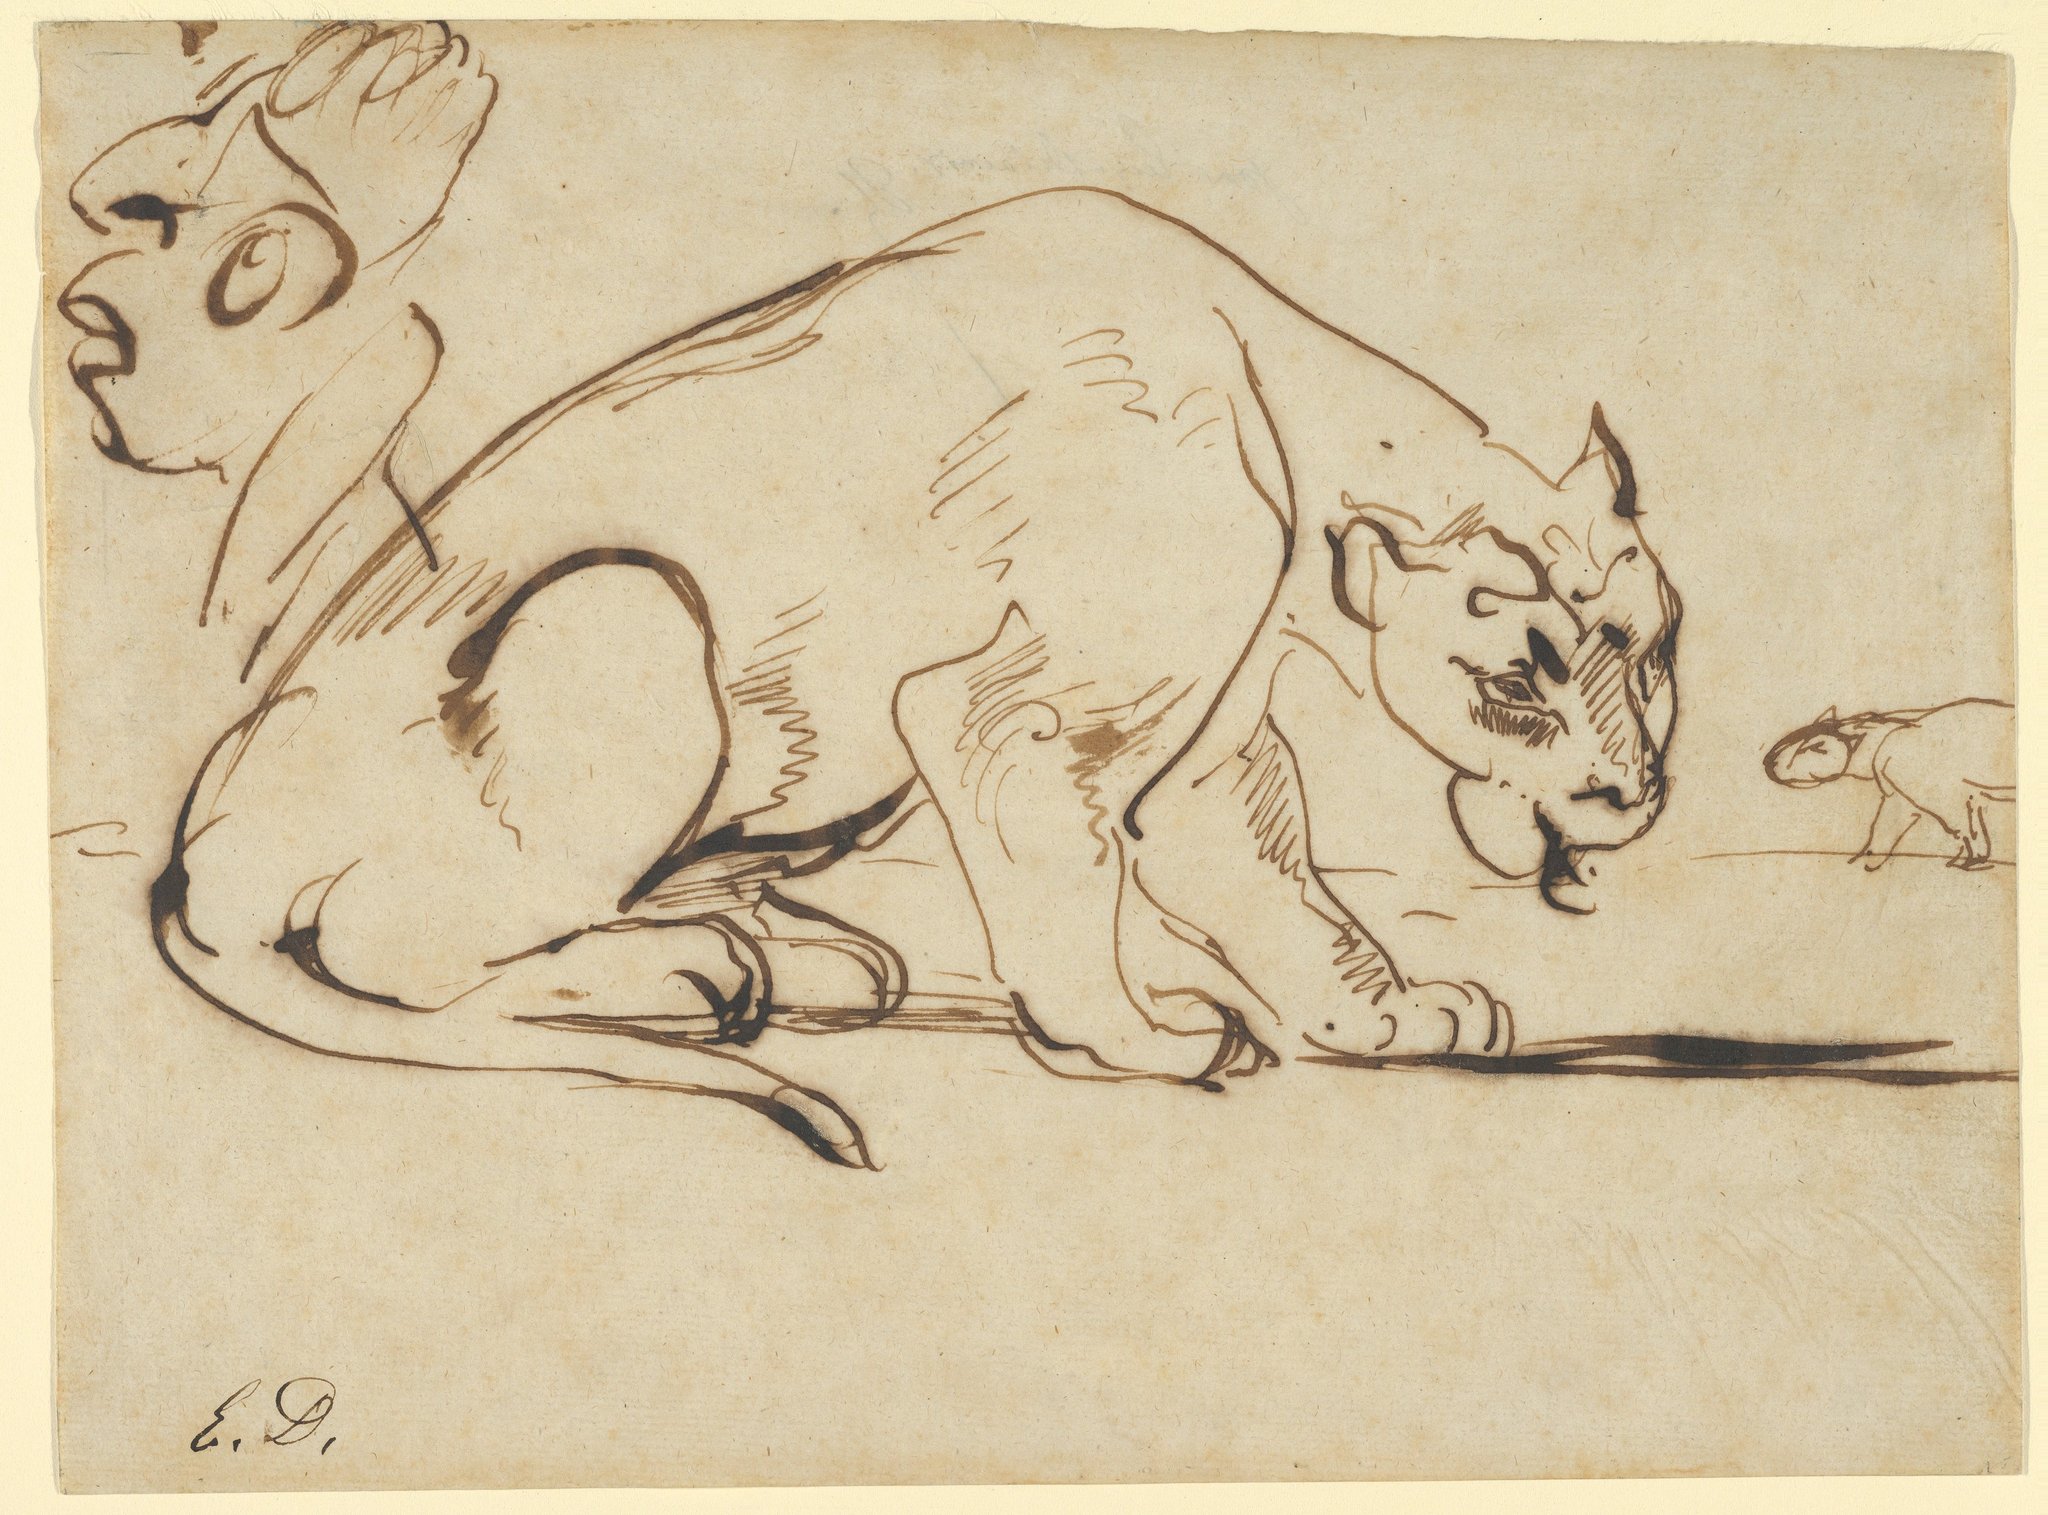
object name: drawing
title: A Lioness and a Caricature of Ingres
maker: eugène delacroix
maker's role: artist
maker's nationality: french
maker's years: 1798-1863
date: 1850-1859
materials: ink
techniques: pen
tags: lions